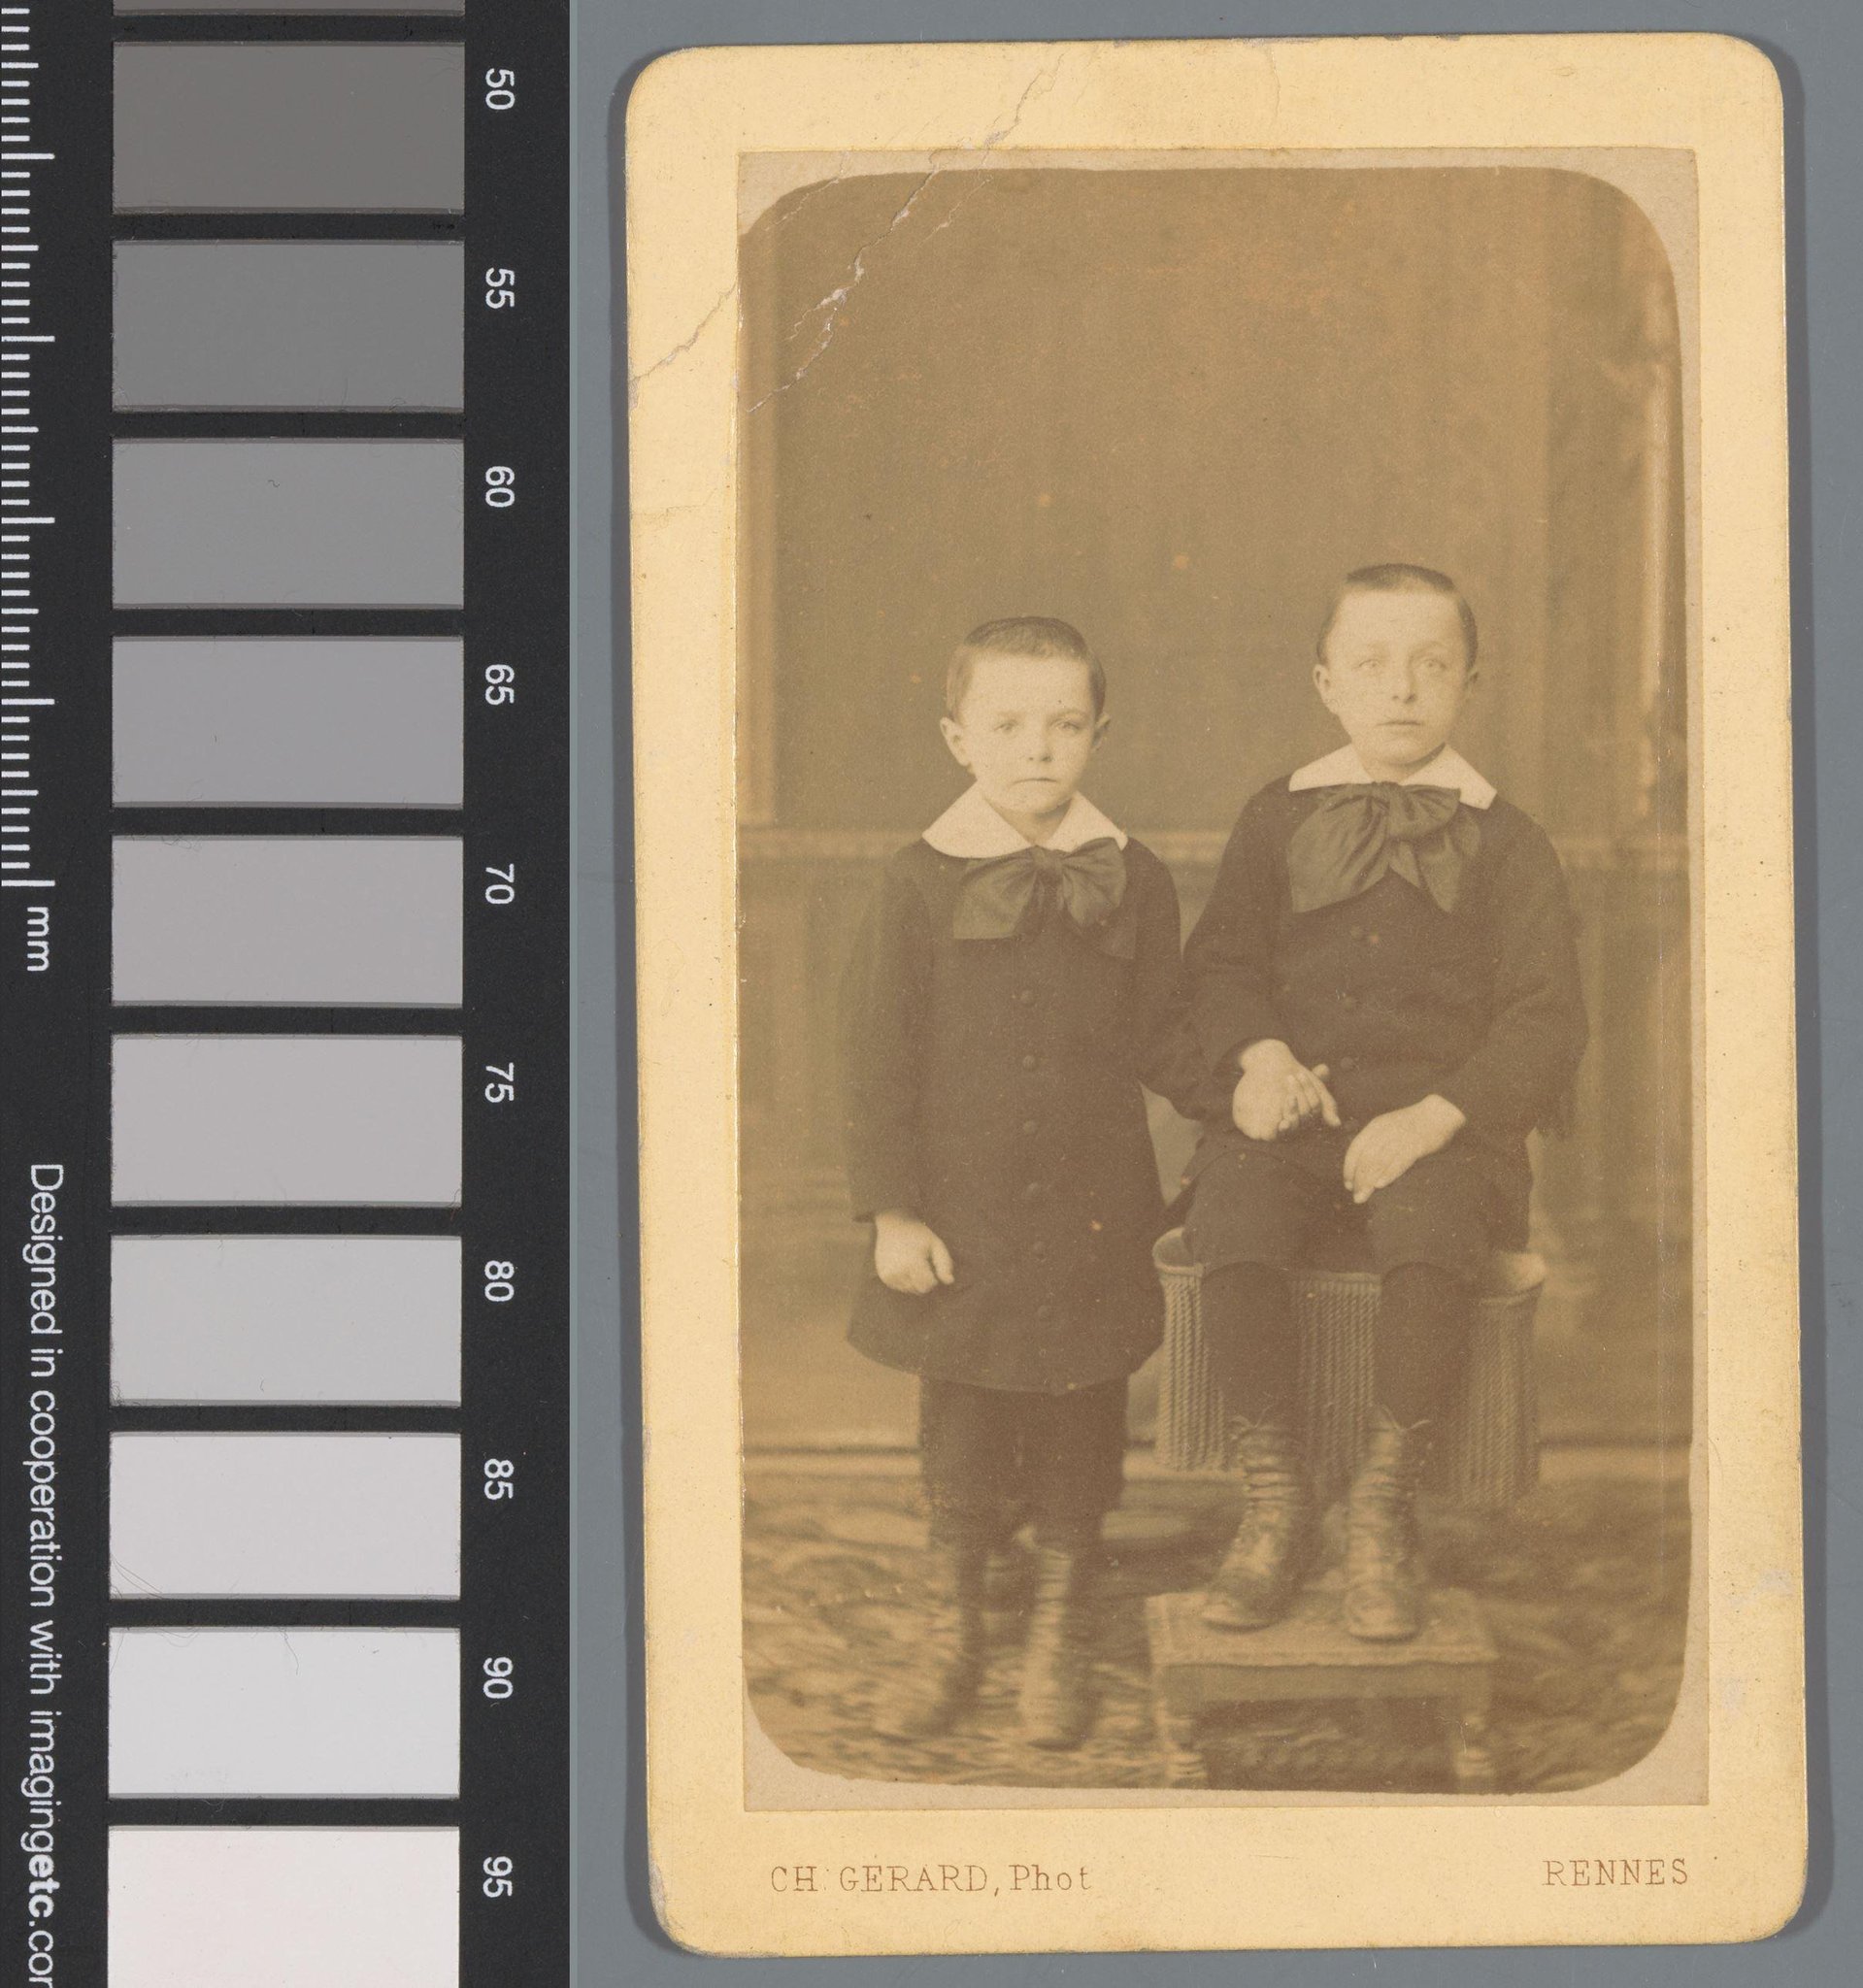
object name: photograph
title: Portret van twee onbekende jongens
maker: charles gérard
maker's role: fotograaf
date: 1862-1885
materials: cardboard, paper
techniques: albumen print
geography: rennes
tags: boy (child between toddler and youth), anonymous historical person portrayed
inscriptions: address: ‘Avenue de la Gare, 55./ RENNES’, number: ‘No 9668’